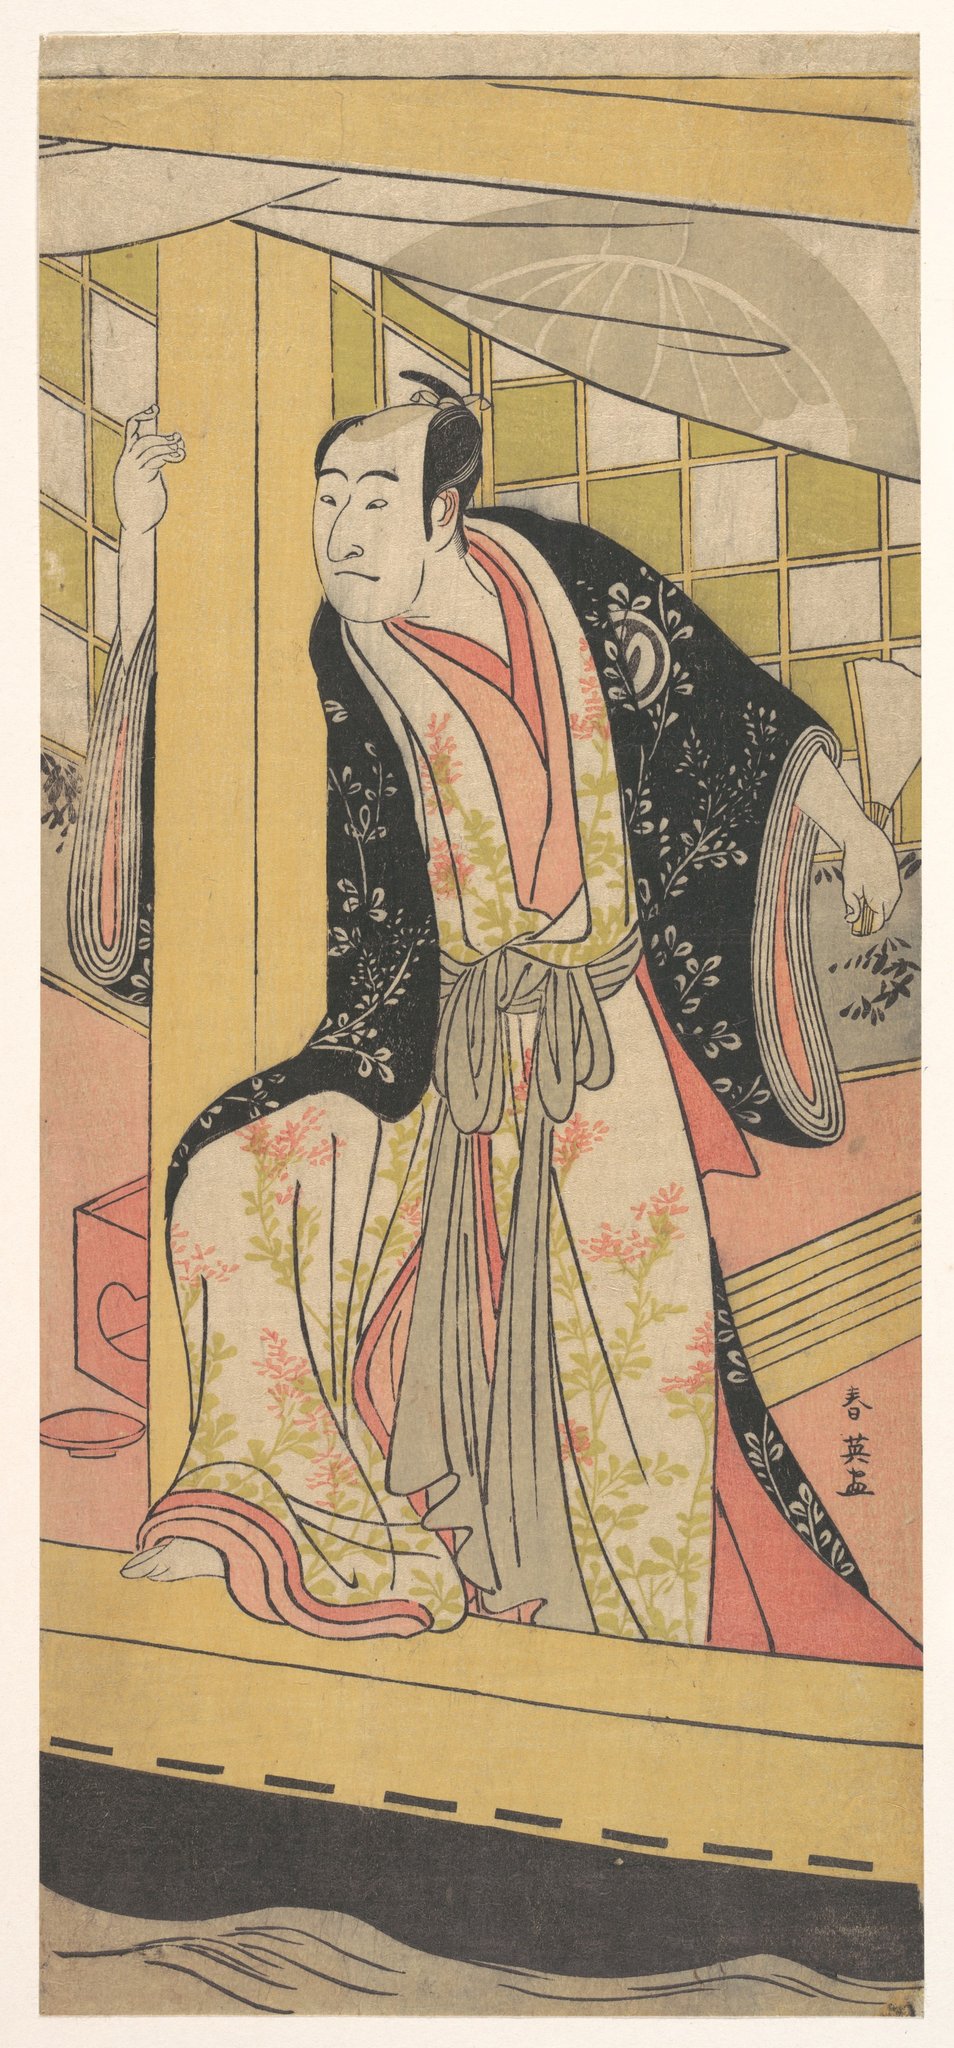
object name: print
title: The Actor Sawamura Sojuro 3rd as a Man Stnding in a Pleasure-boat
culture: japanese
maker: katsukawa shun'ei 勝川春英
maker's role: artist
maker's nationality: japanese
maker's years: 1762-1819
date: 1790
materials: ink, paper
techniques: woodblock print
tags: men,actors,boats